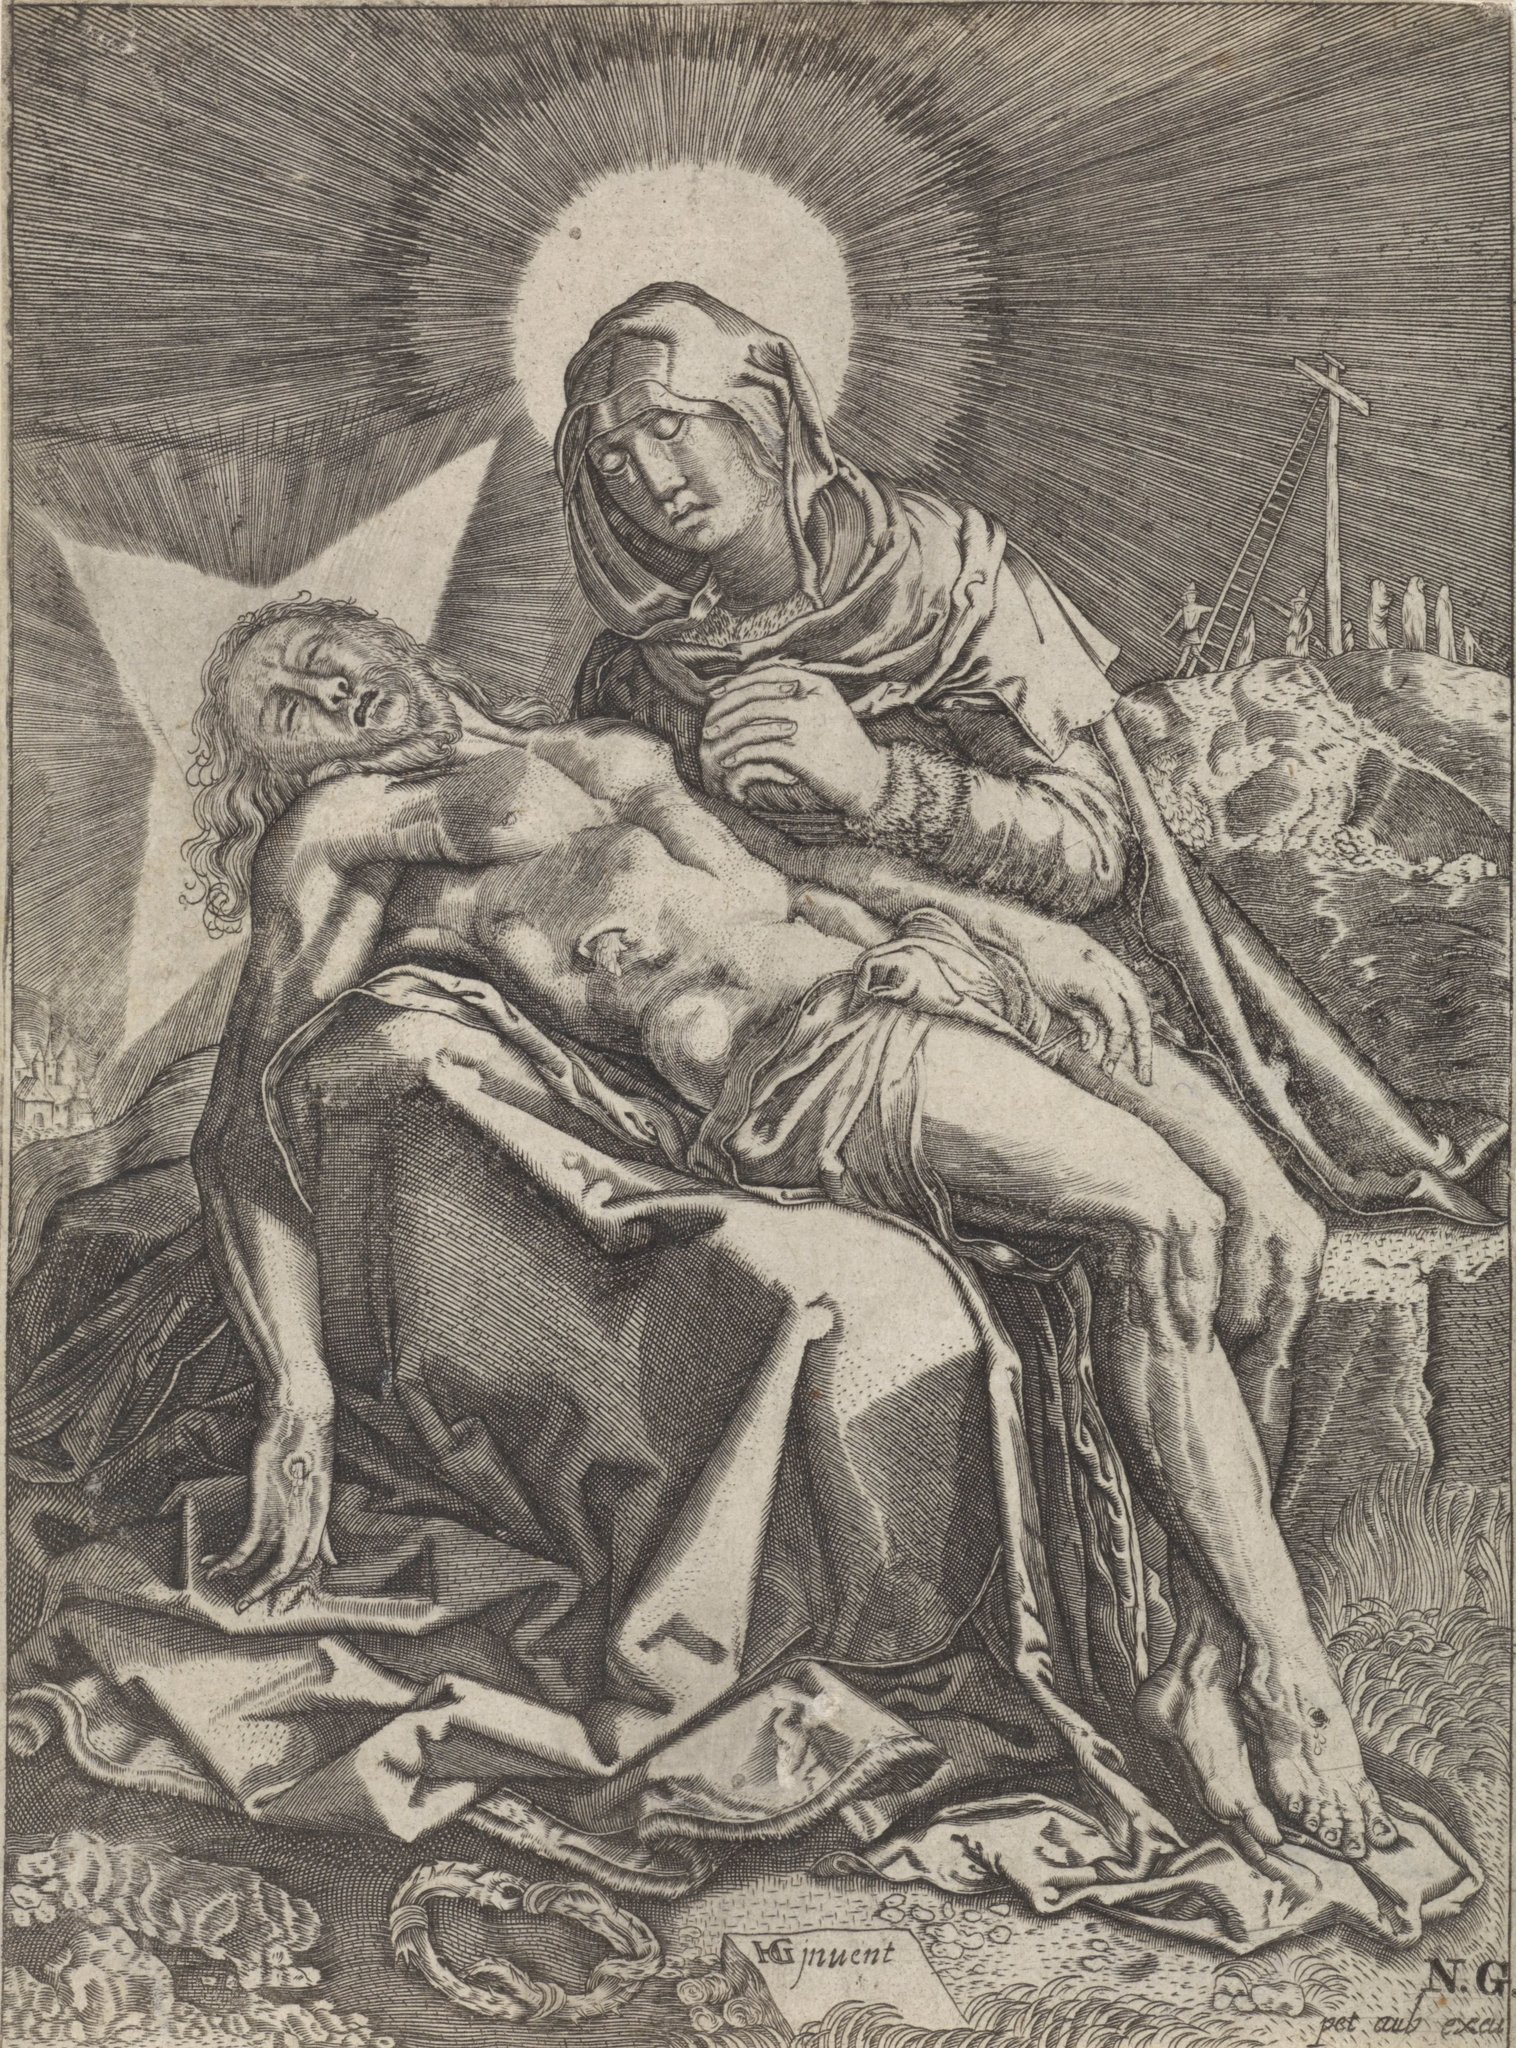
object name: print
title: Piëta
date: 1628-1686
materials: paper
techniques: engraving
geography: straatsburg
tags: 'pietà ', 'vesperbild', 'marienklage' (no others present): christ, either with or without crown of thorns, mourned by mary, the dead christ in mary's lap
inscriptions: collector's mark: Lugt 2228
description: Maria met de gestorven Christus in de armen, hem bewenend, zittend op een steen.